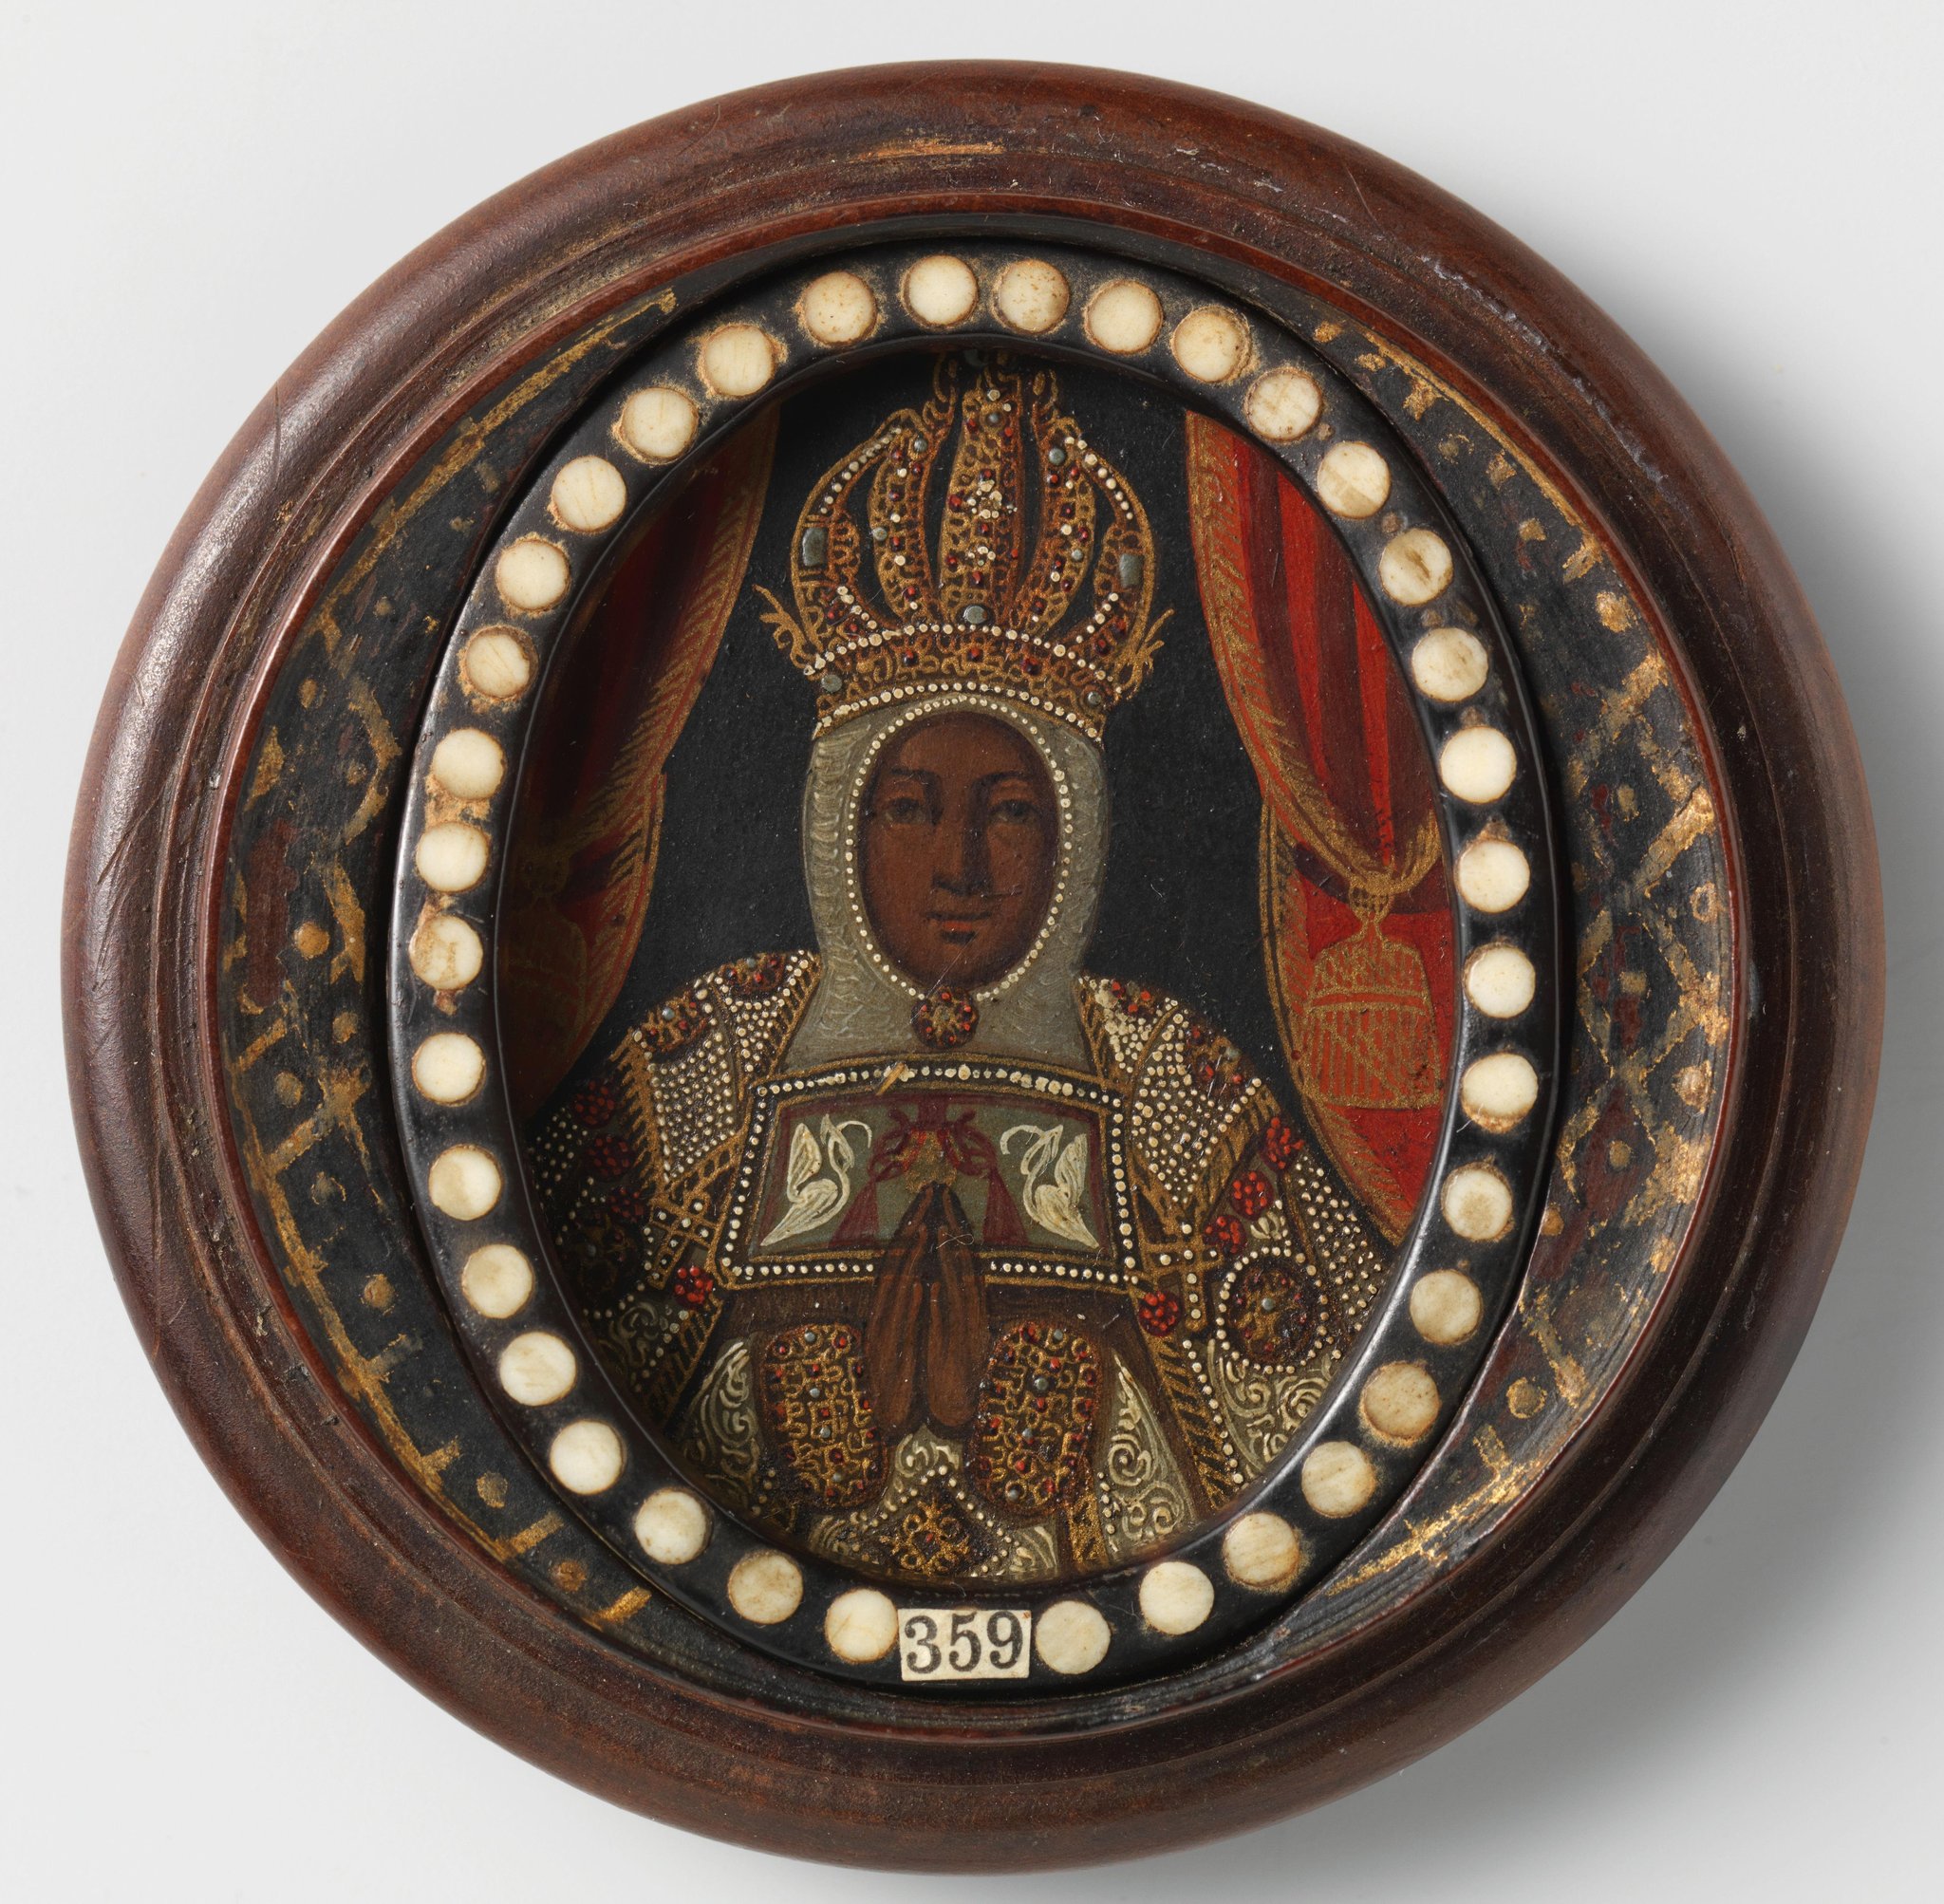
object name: box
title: Black Madonna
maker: Anonymous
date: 1650-1699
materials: copper, ivory, oil, wood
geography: south america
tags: madonna: i.e. mary with the christ-child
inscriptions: inscription: ‘Effigies Montezumae imperatoris Mexici per Ferdinandum del Campo ad vivam imaginem facta’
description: Beeltenis van de Zwarte Madonna, buste, op de binnenzijde van een rond doosje. Met een inscriptie op de binnenzijde van de deksel.